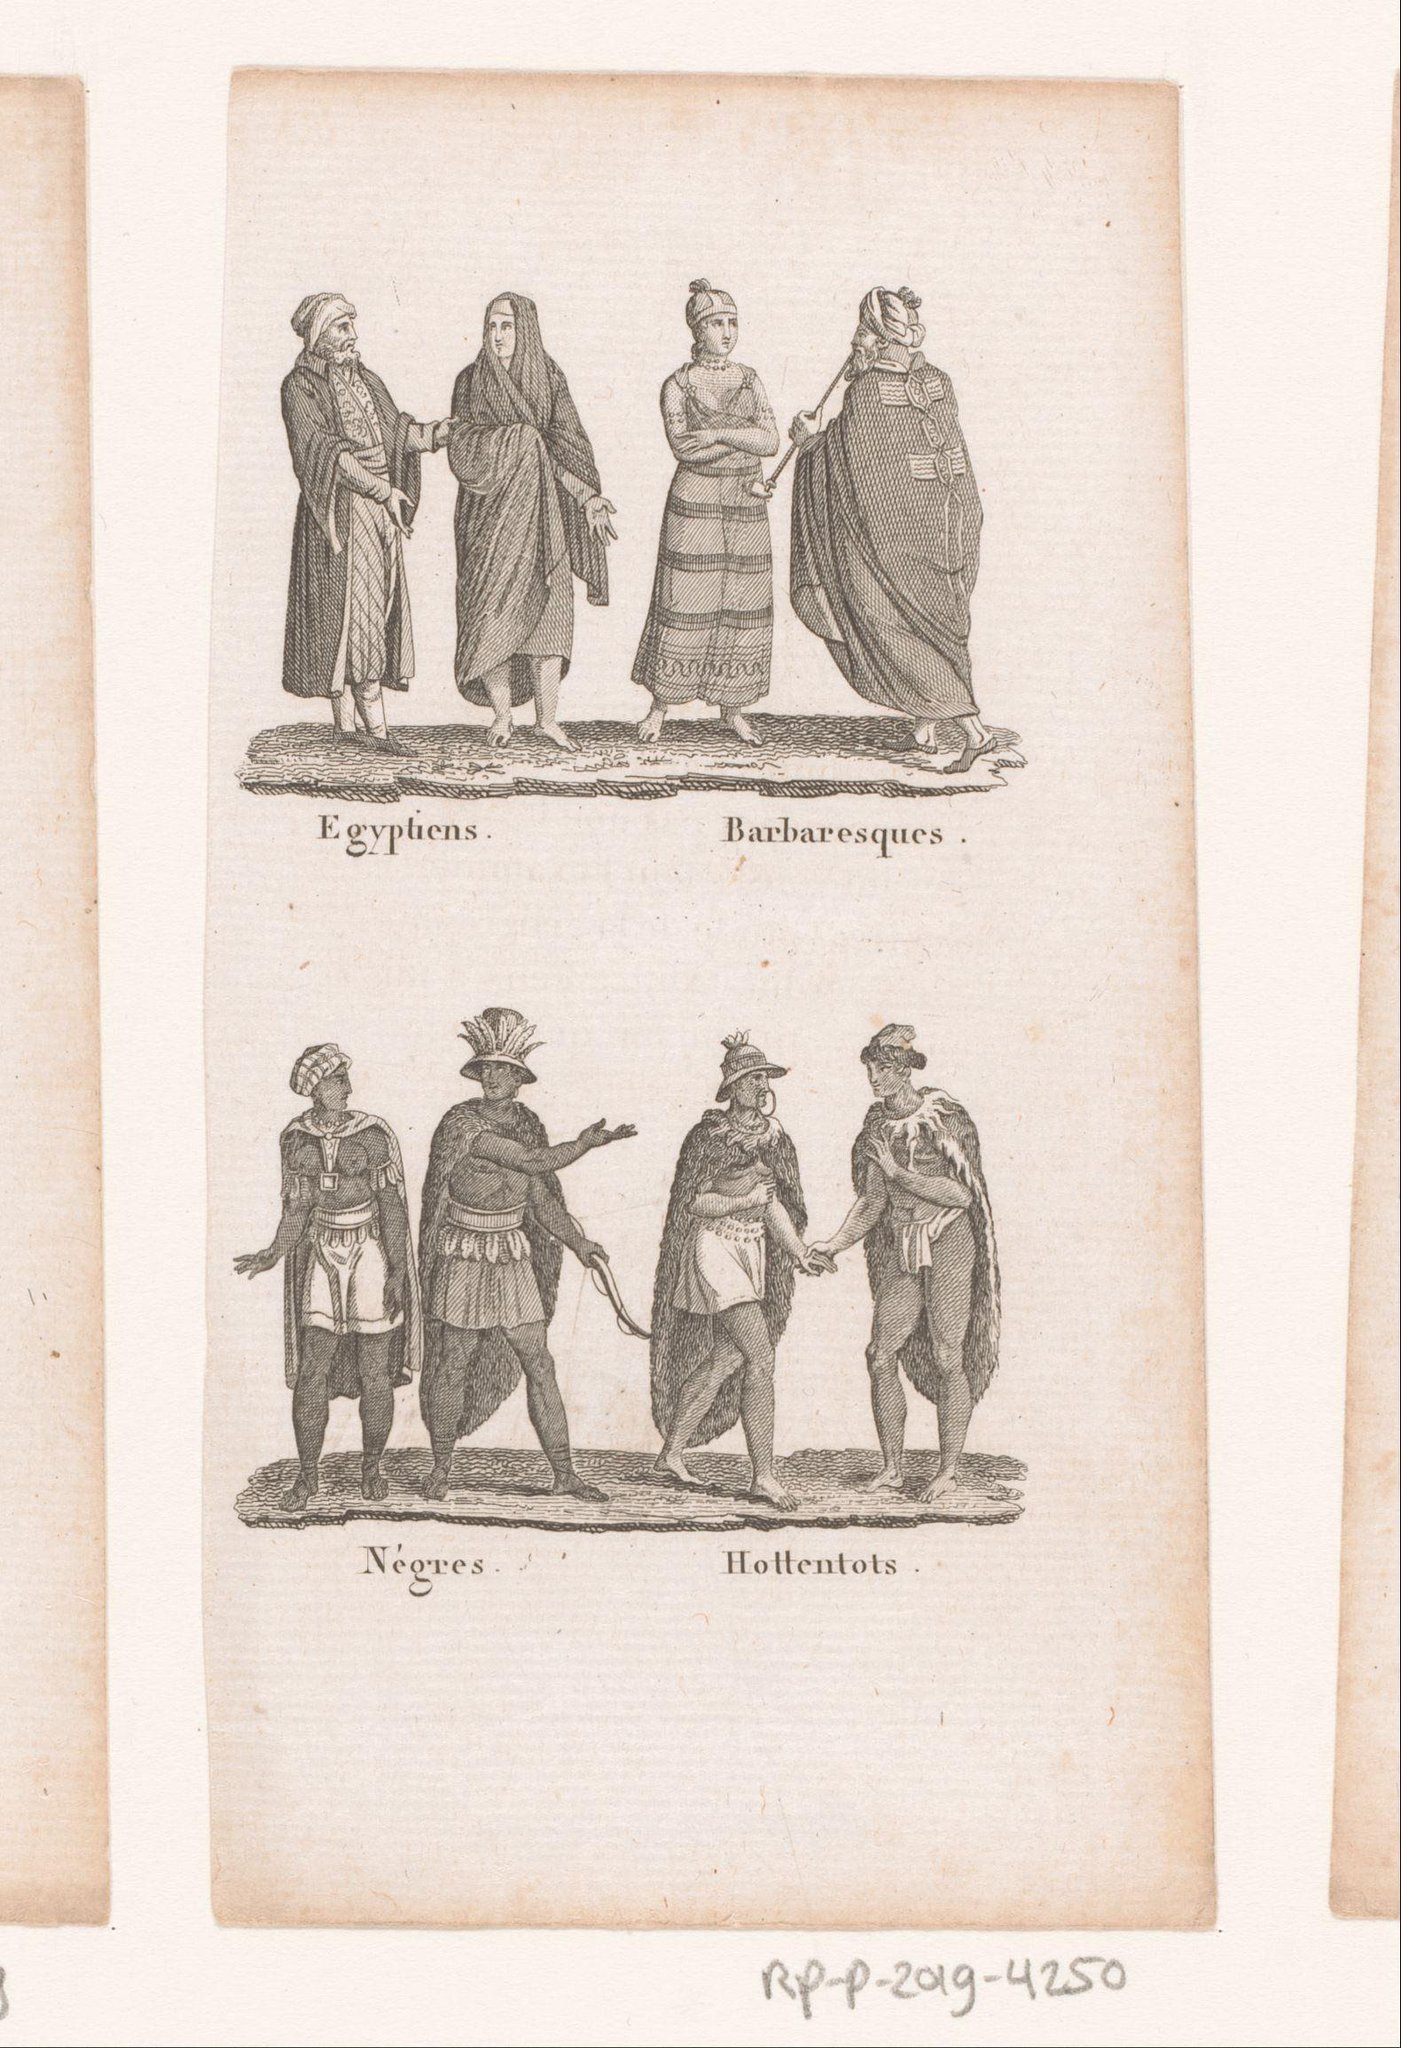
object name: book illustration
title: Egyptiens, Barbaresques, Négres, Hottentots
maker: Anonymous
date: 1750-1800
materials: paper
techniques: etching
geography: france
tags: asiatic races and peoples (egyptians), africans, africans (berbers), khoikhoi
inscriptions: collector's mark: Lugt 2228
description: Prent uit een onbekende publicatie, zie ook bijvoorbeeld RP-P-2019-4248 en RP-P-2019-4249.